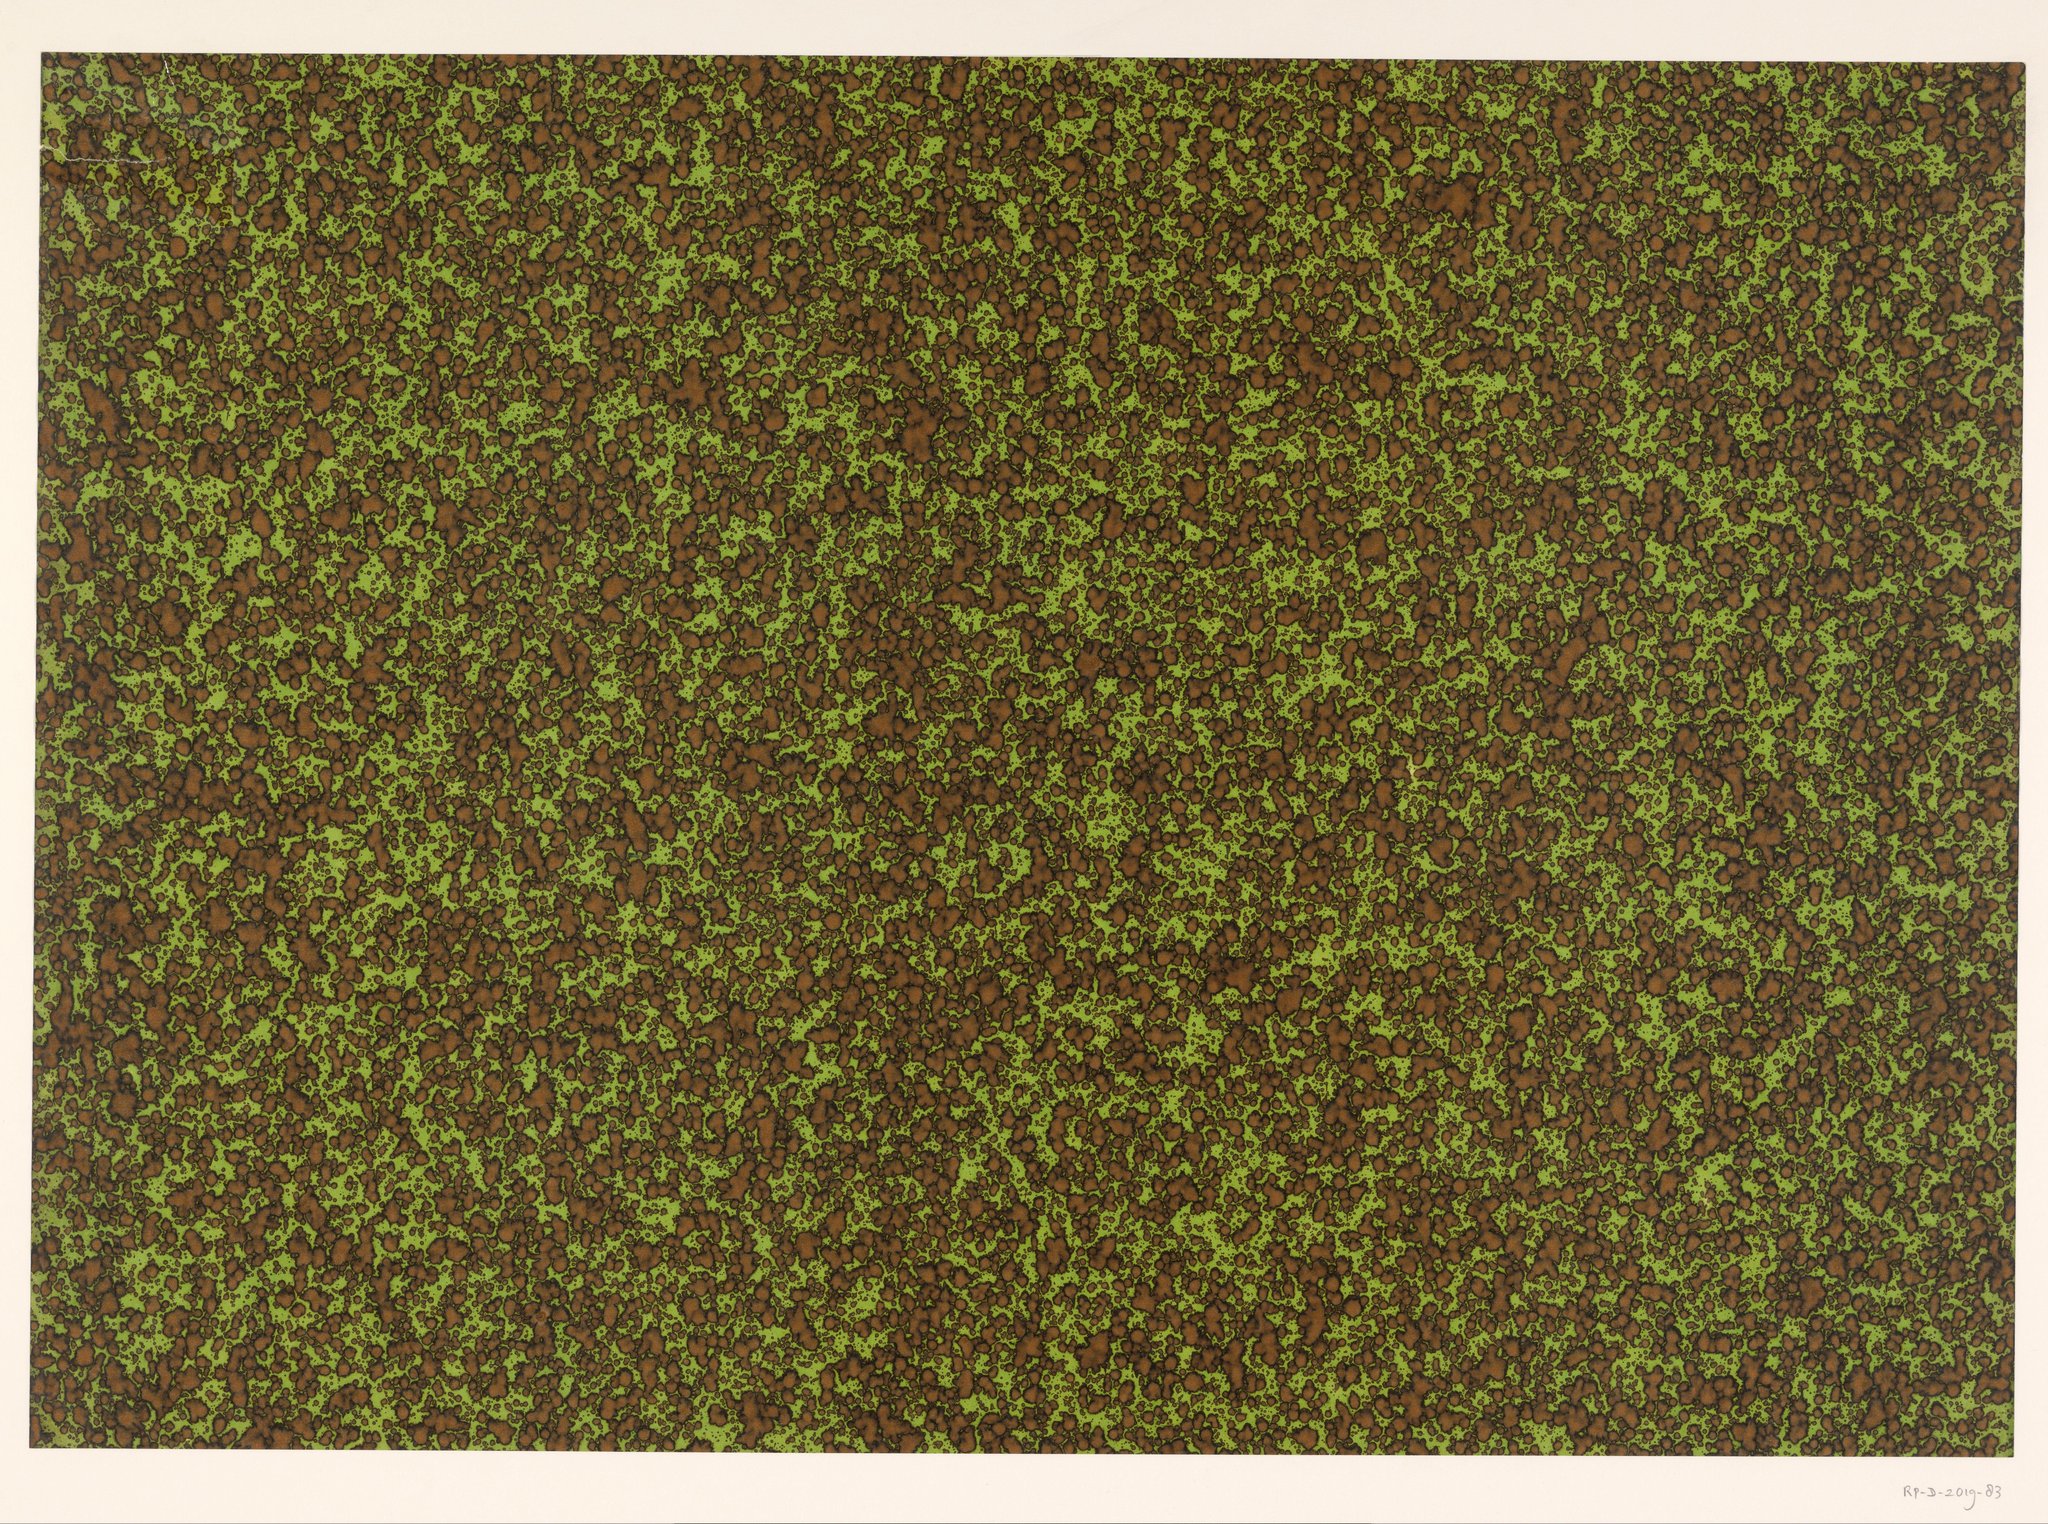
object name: sprinkled paper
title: Gustavmarmer in bruin op groen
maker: Anonymous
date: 1900-2000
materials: lacquer, paint, paper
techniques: marbled paper